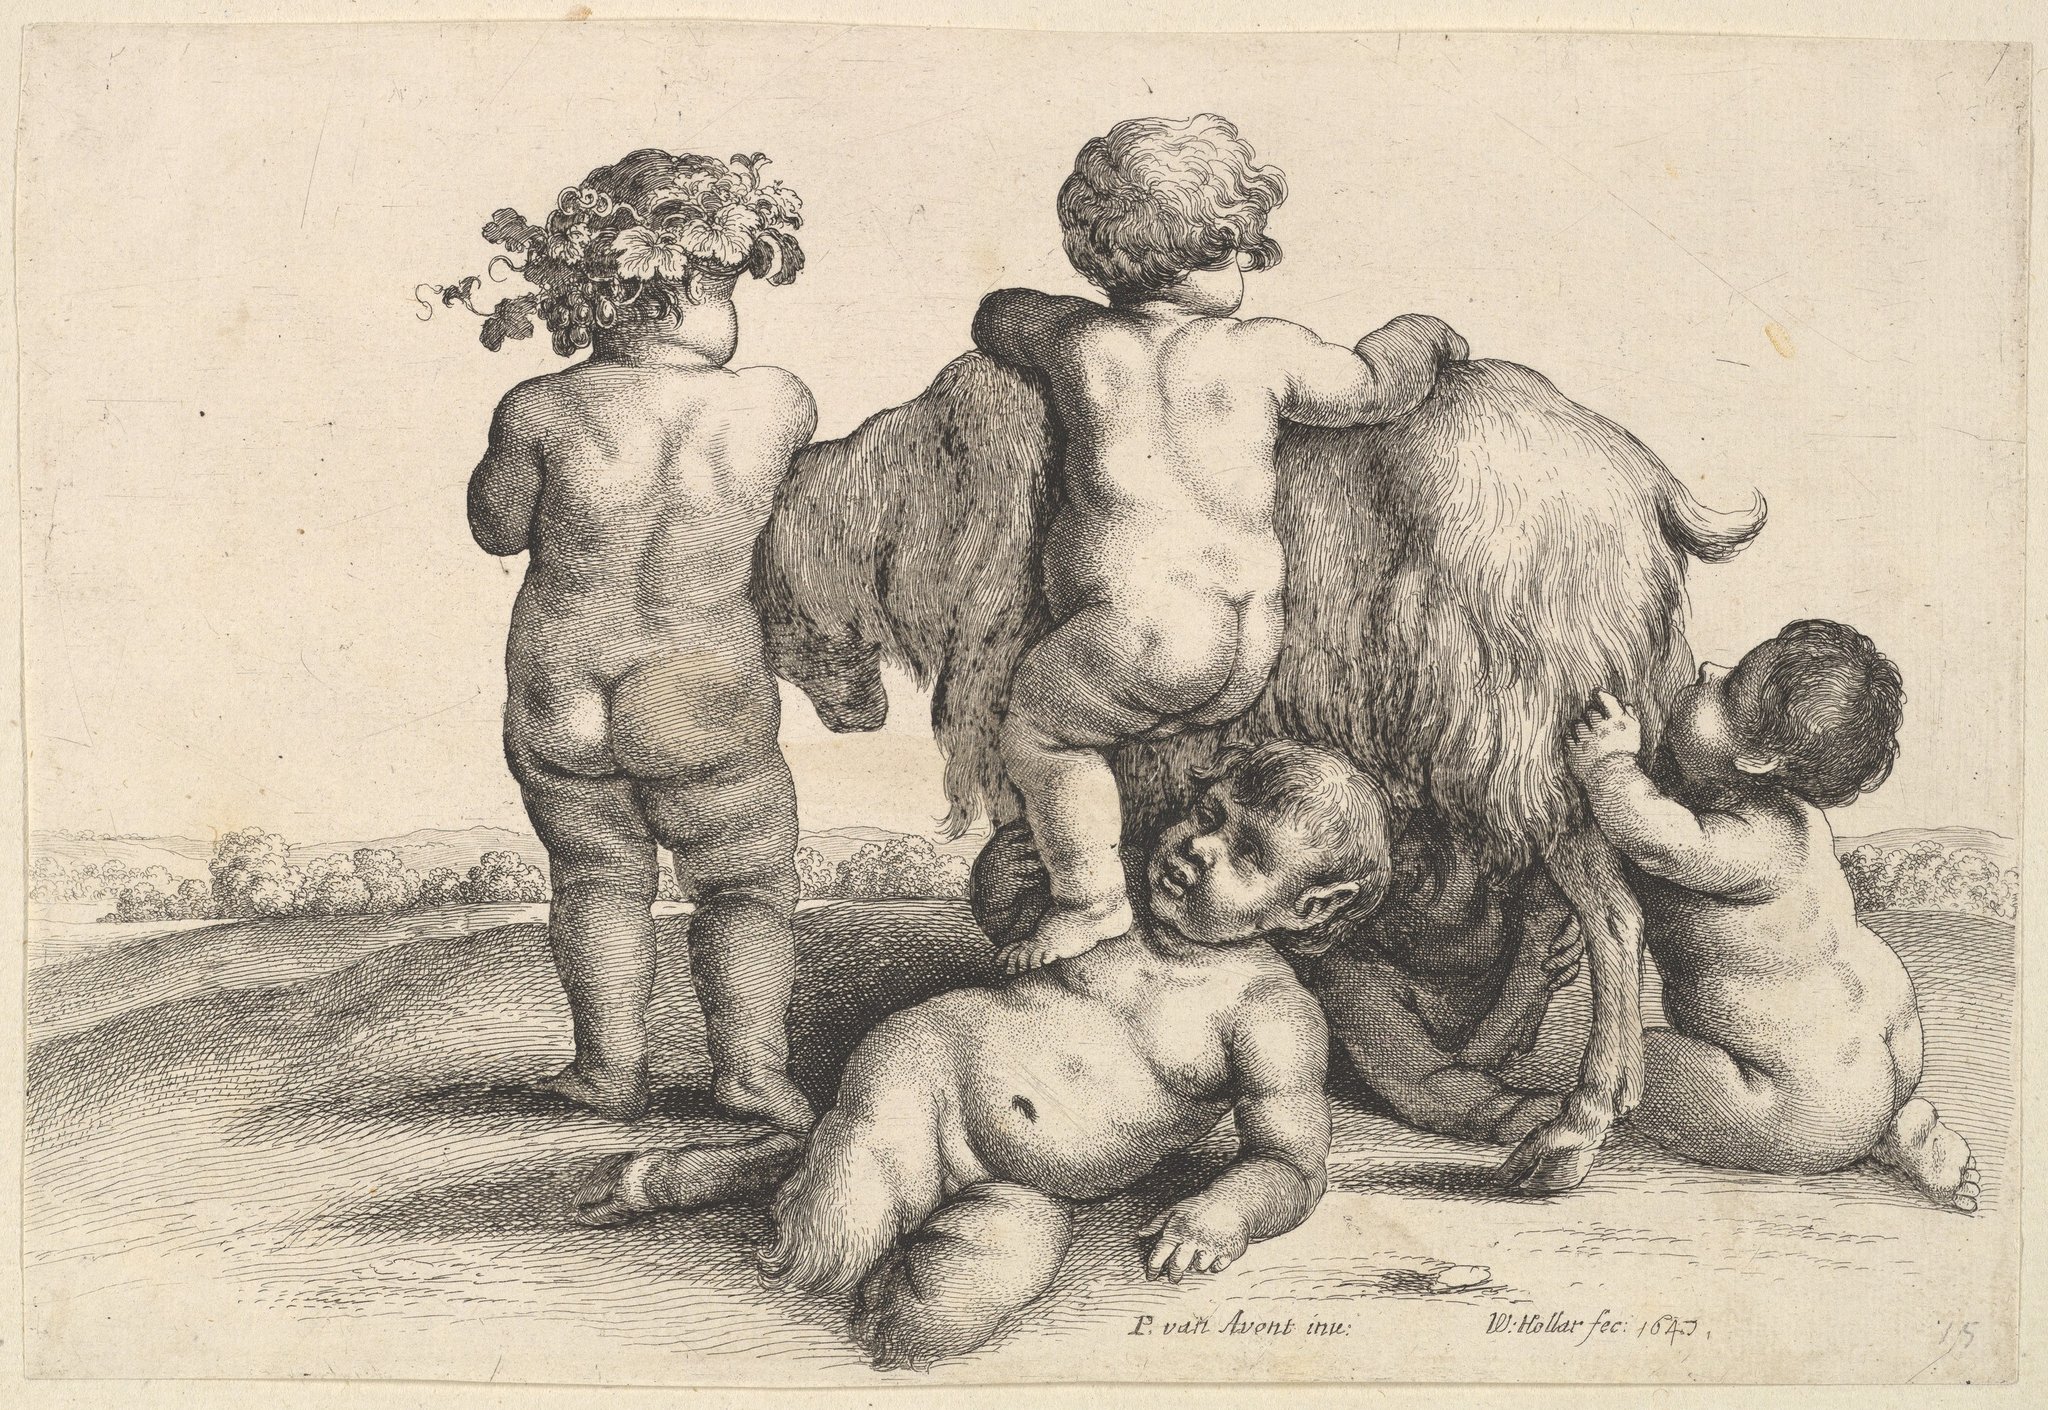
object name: print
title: Four boys, a young satyr and a goat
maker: wenceslaus hollar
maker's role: artist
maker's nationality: bohemian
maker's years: 1607-1677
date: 1647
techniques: etching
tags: boys,satyrs,goats,wreaths